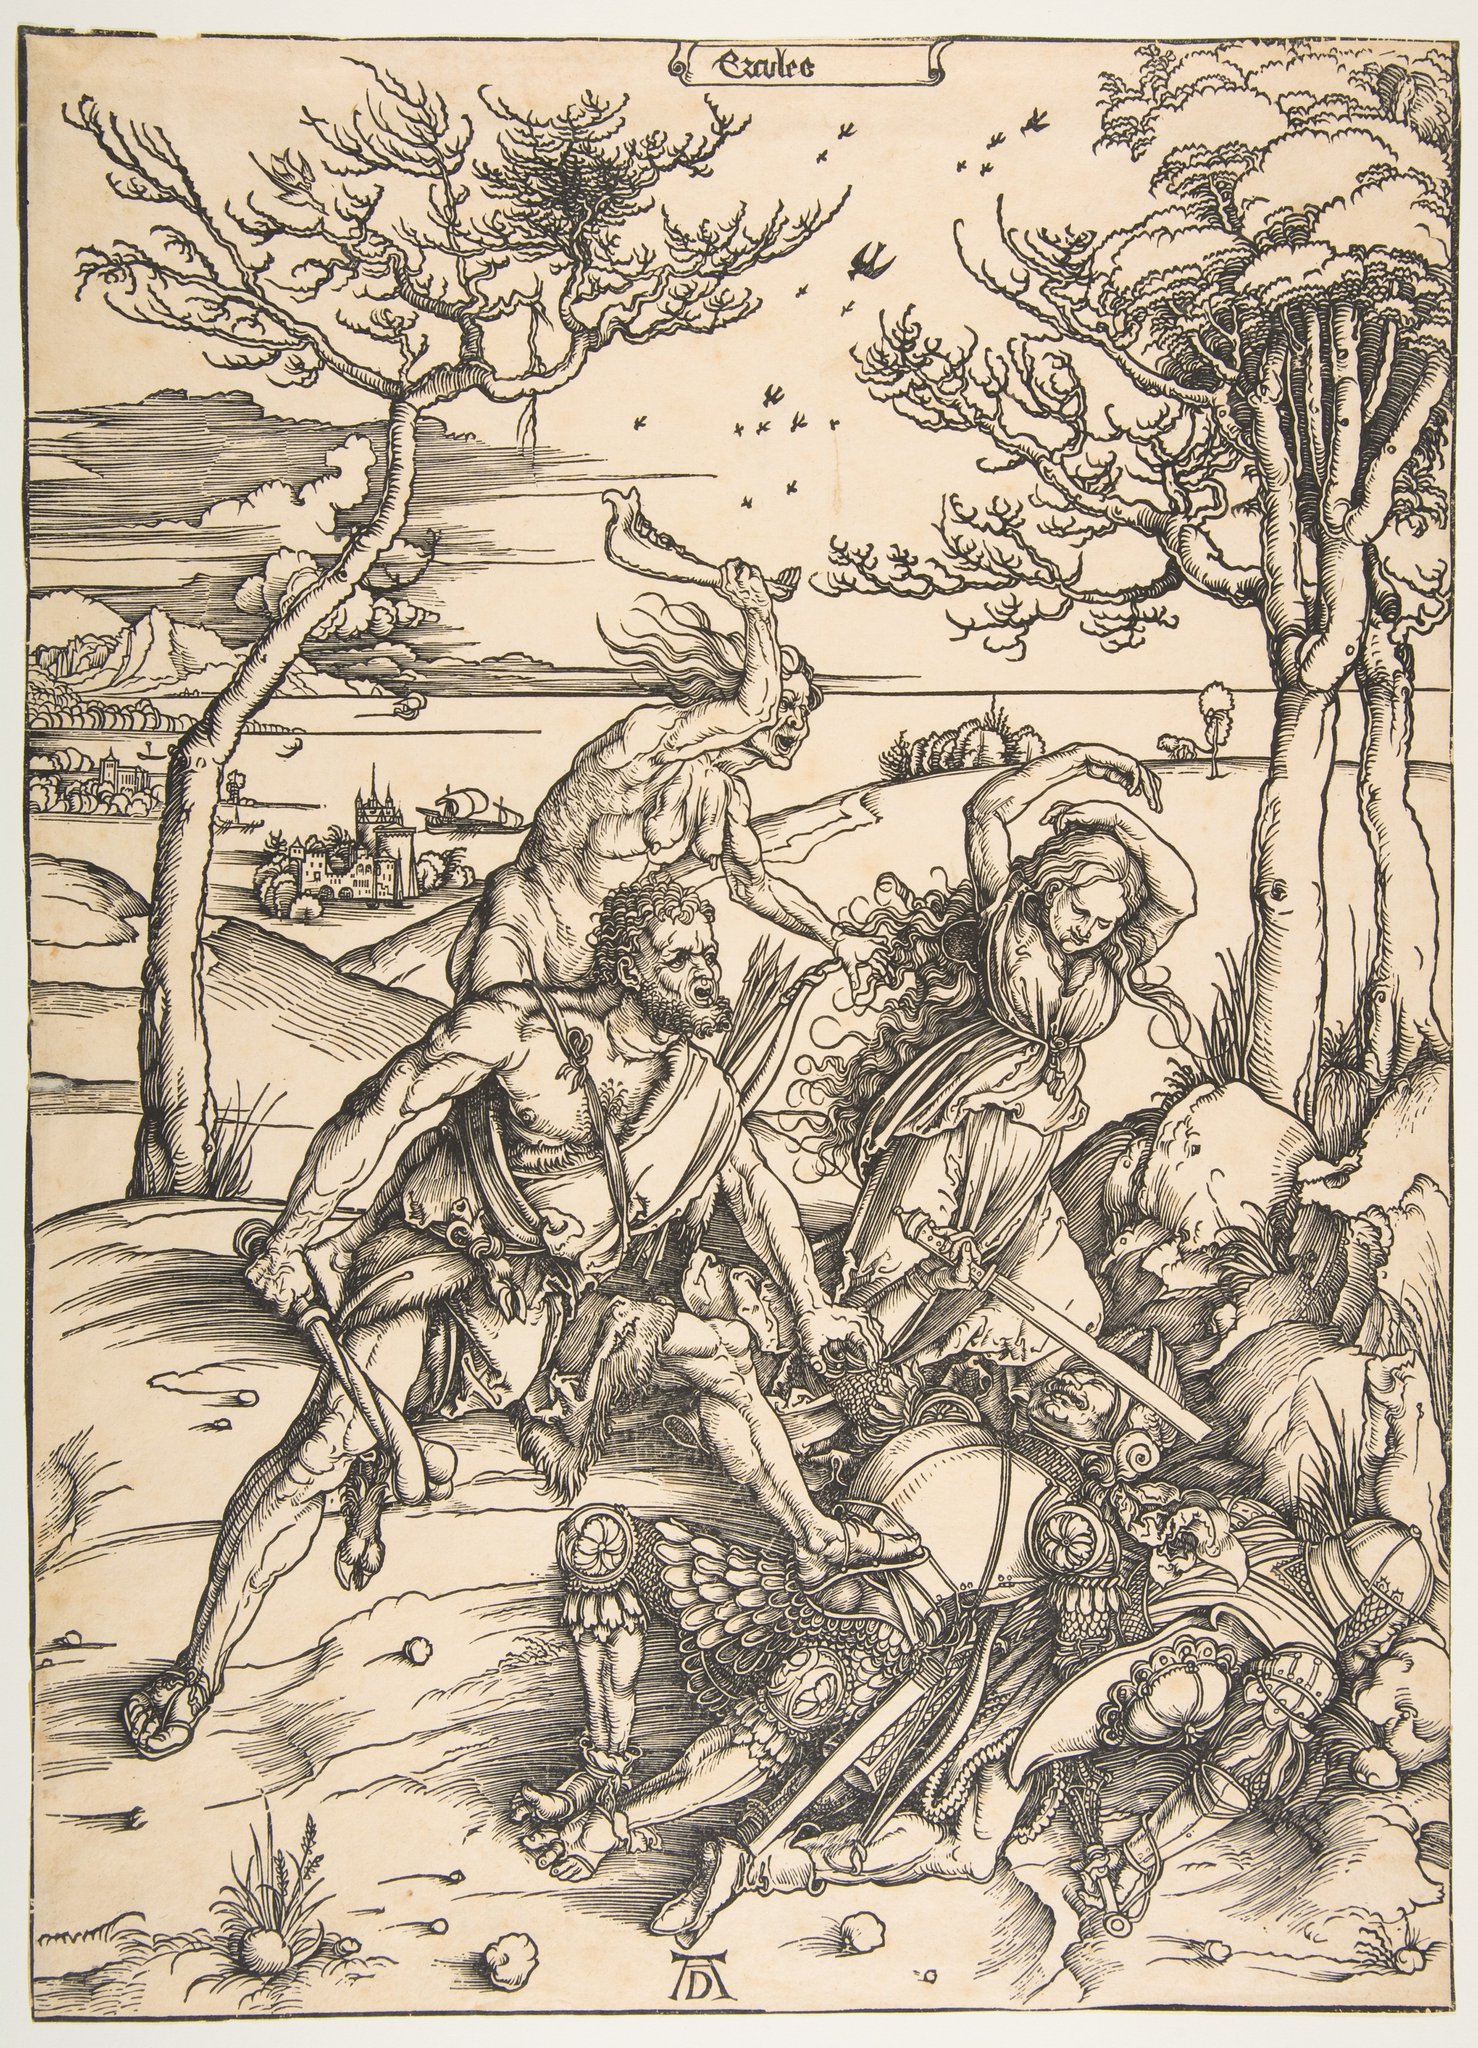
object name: print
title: Hercules Conquering the Molionide Twins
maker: albrecht dürer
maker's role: artist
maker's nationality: german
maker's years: 1471-1528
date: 1496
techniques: woodcut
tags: swords,women,hercules,trees